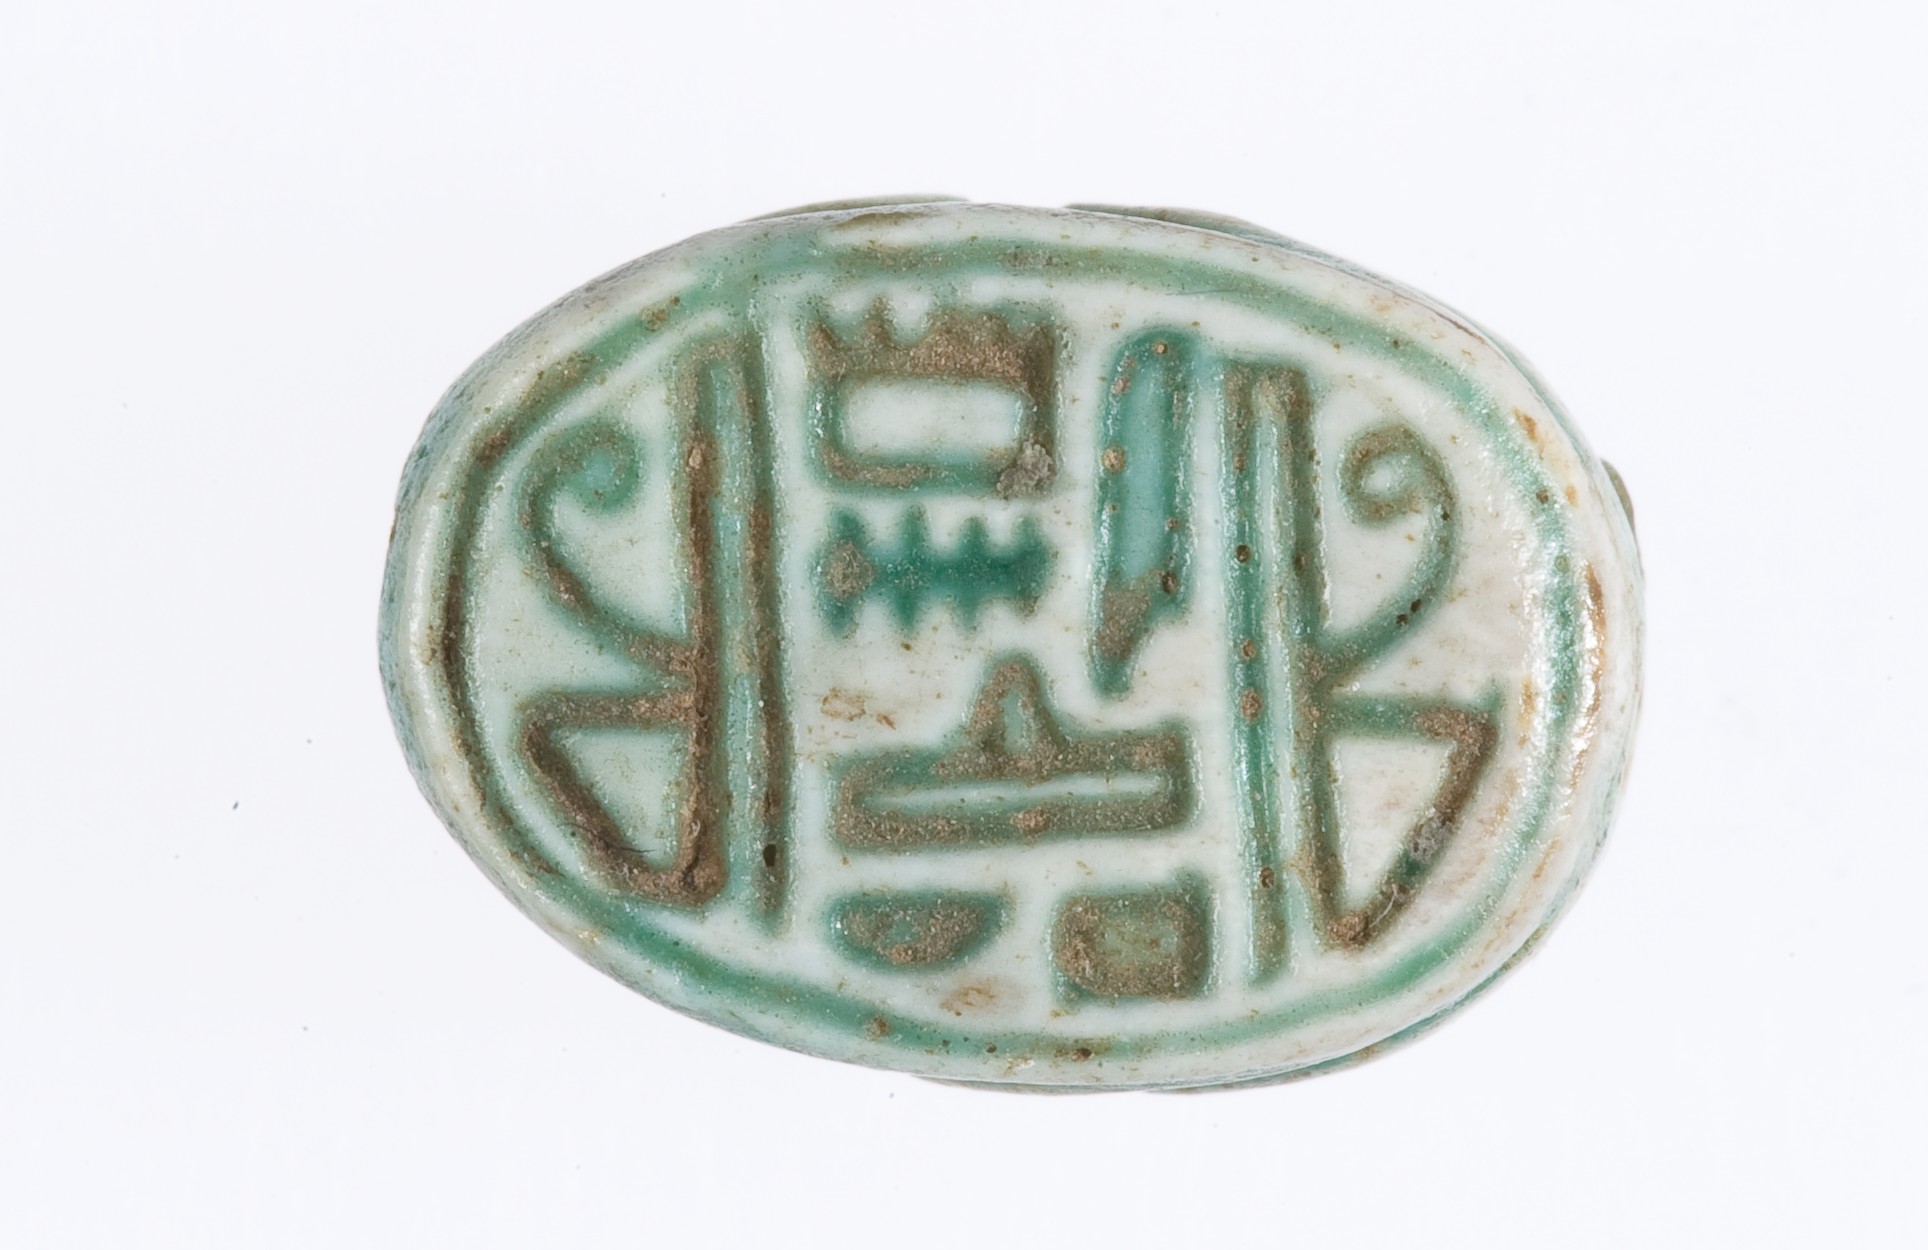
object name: scarab, amenhotep, red crown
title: Scarab Inscribed With the Name Amenhotep Flanked by Two Red Crowns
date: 1525-1504 BCE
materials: stone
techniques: glazing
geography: egypt